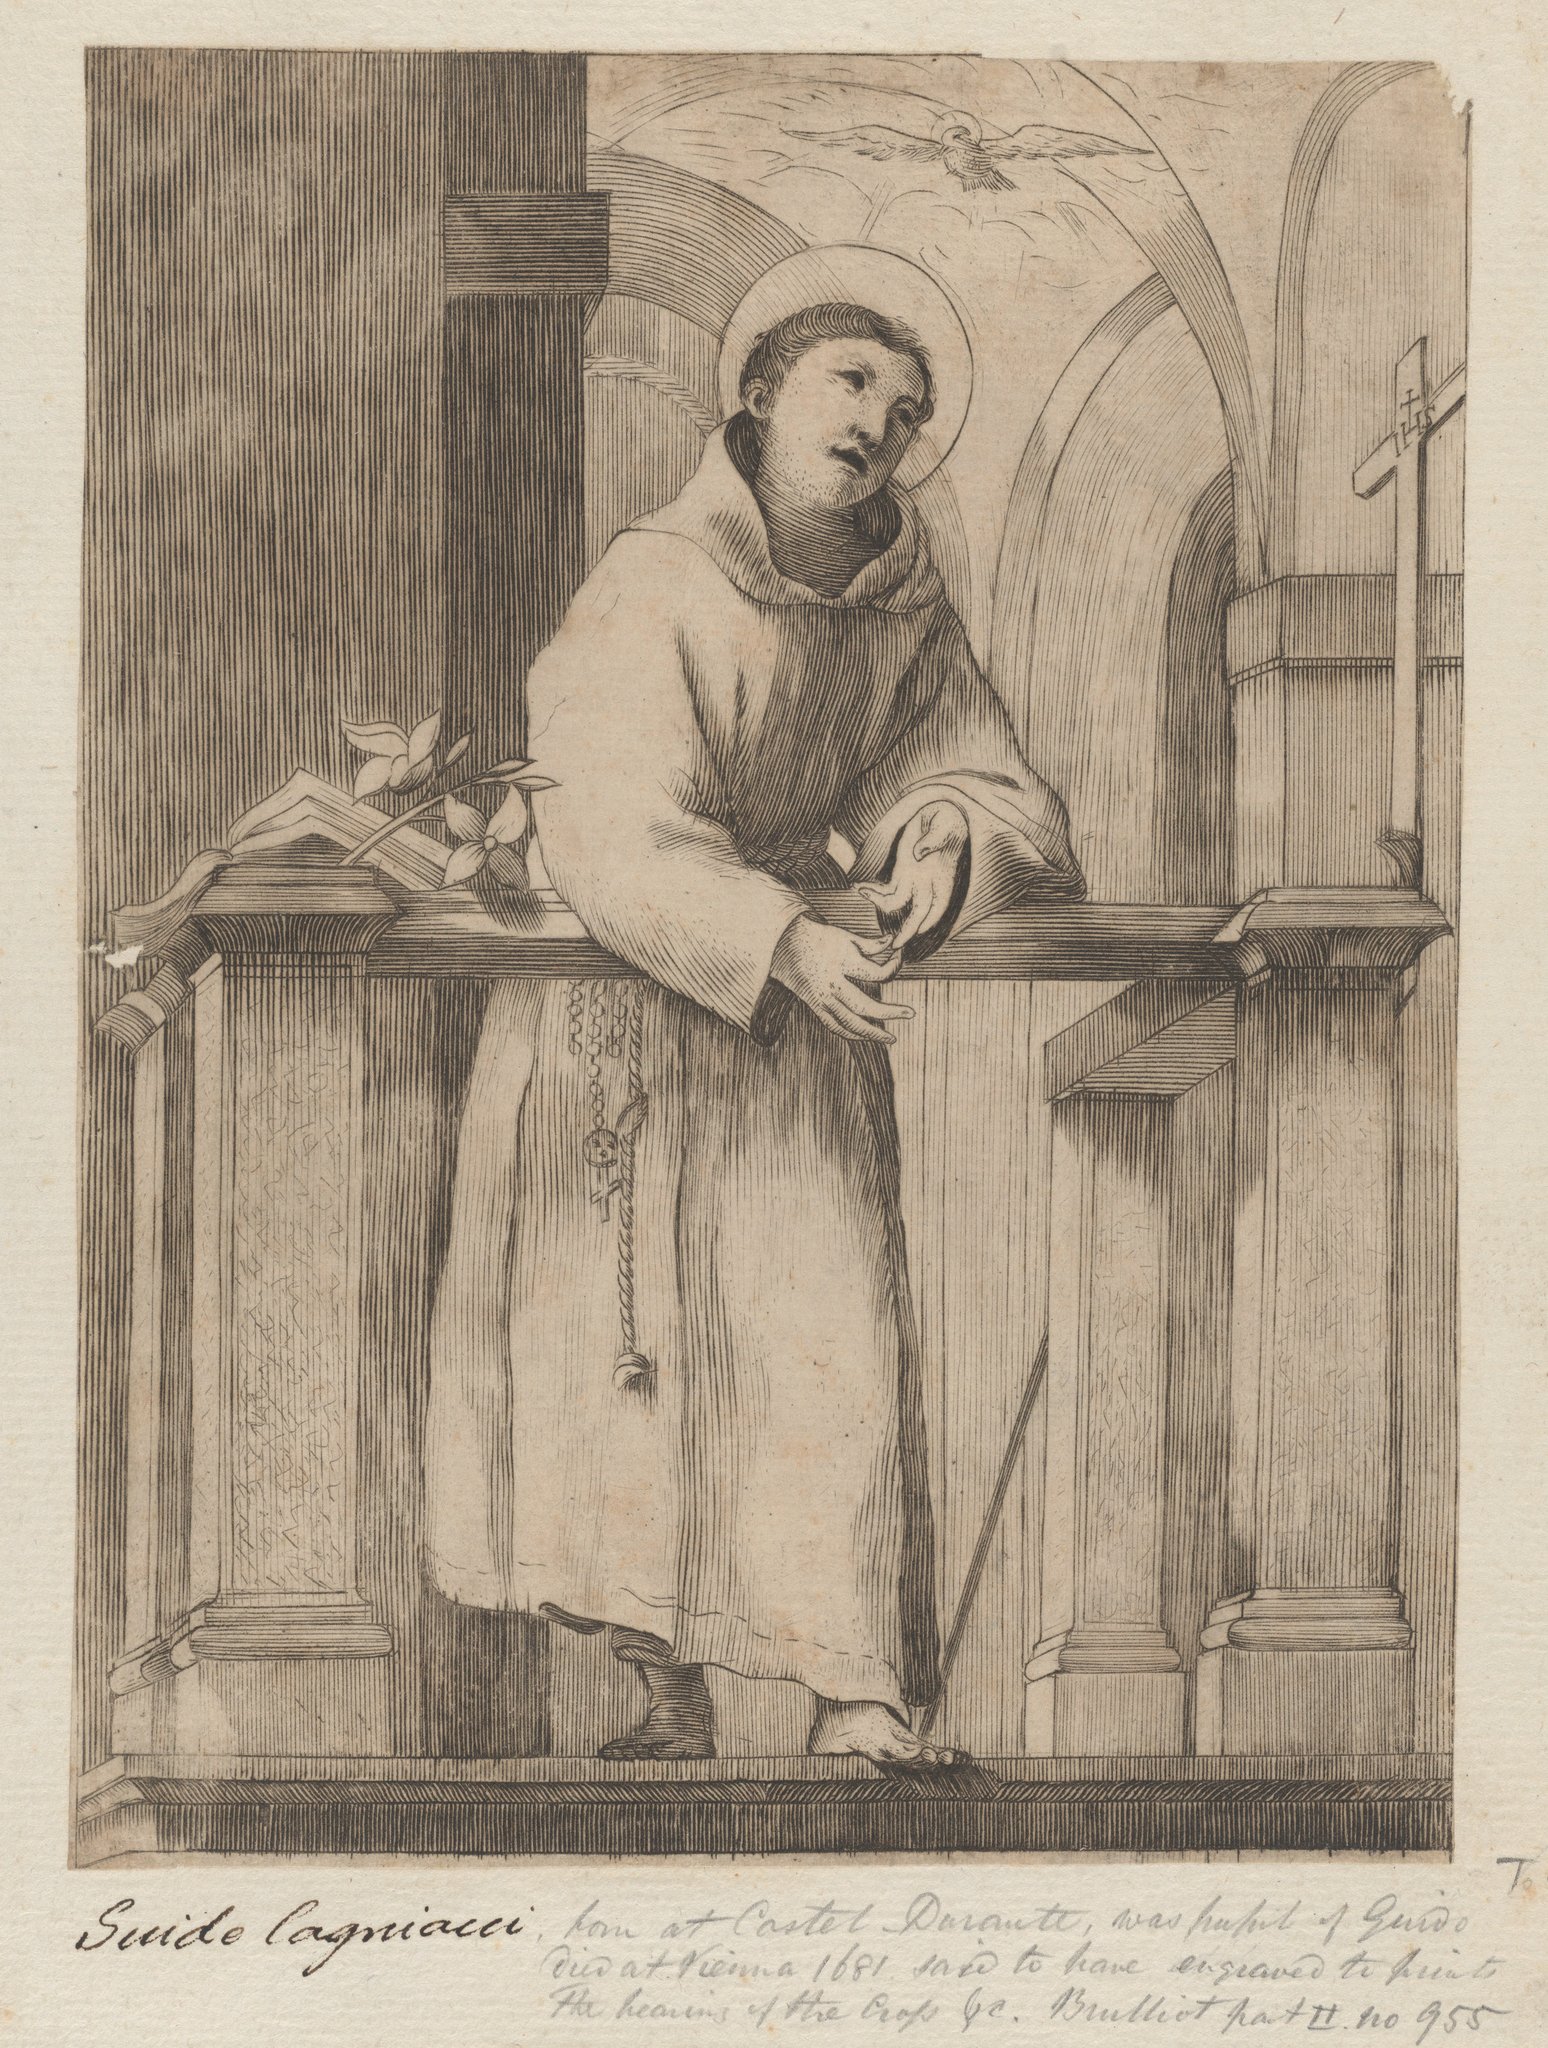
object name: print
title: Saint Anthony of Padua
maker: Anonymous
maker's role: artist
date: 1650-1700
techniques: etching